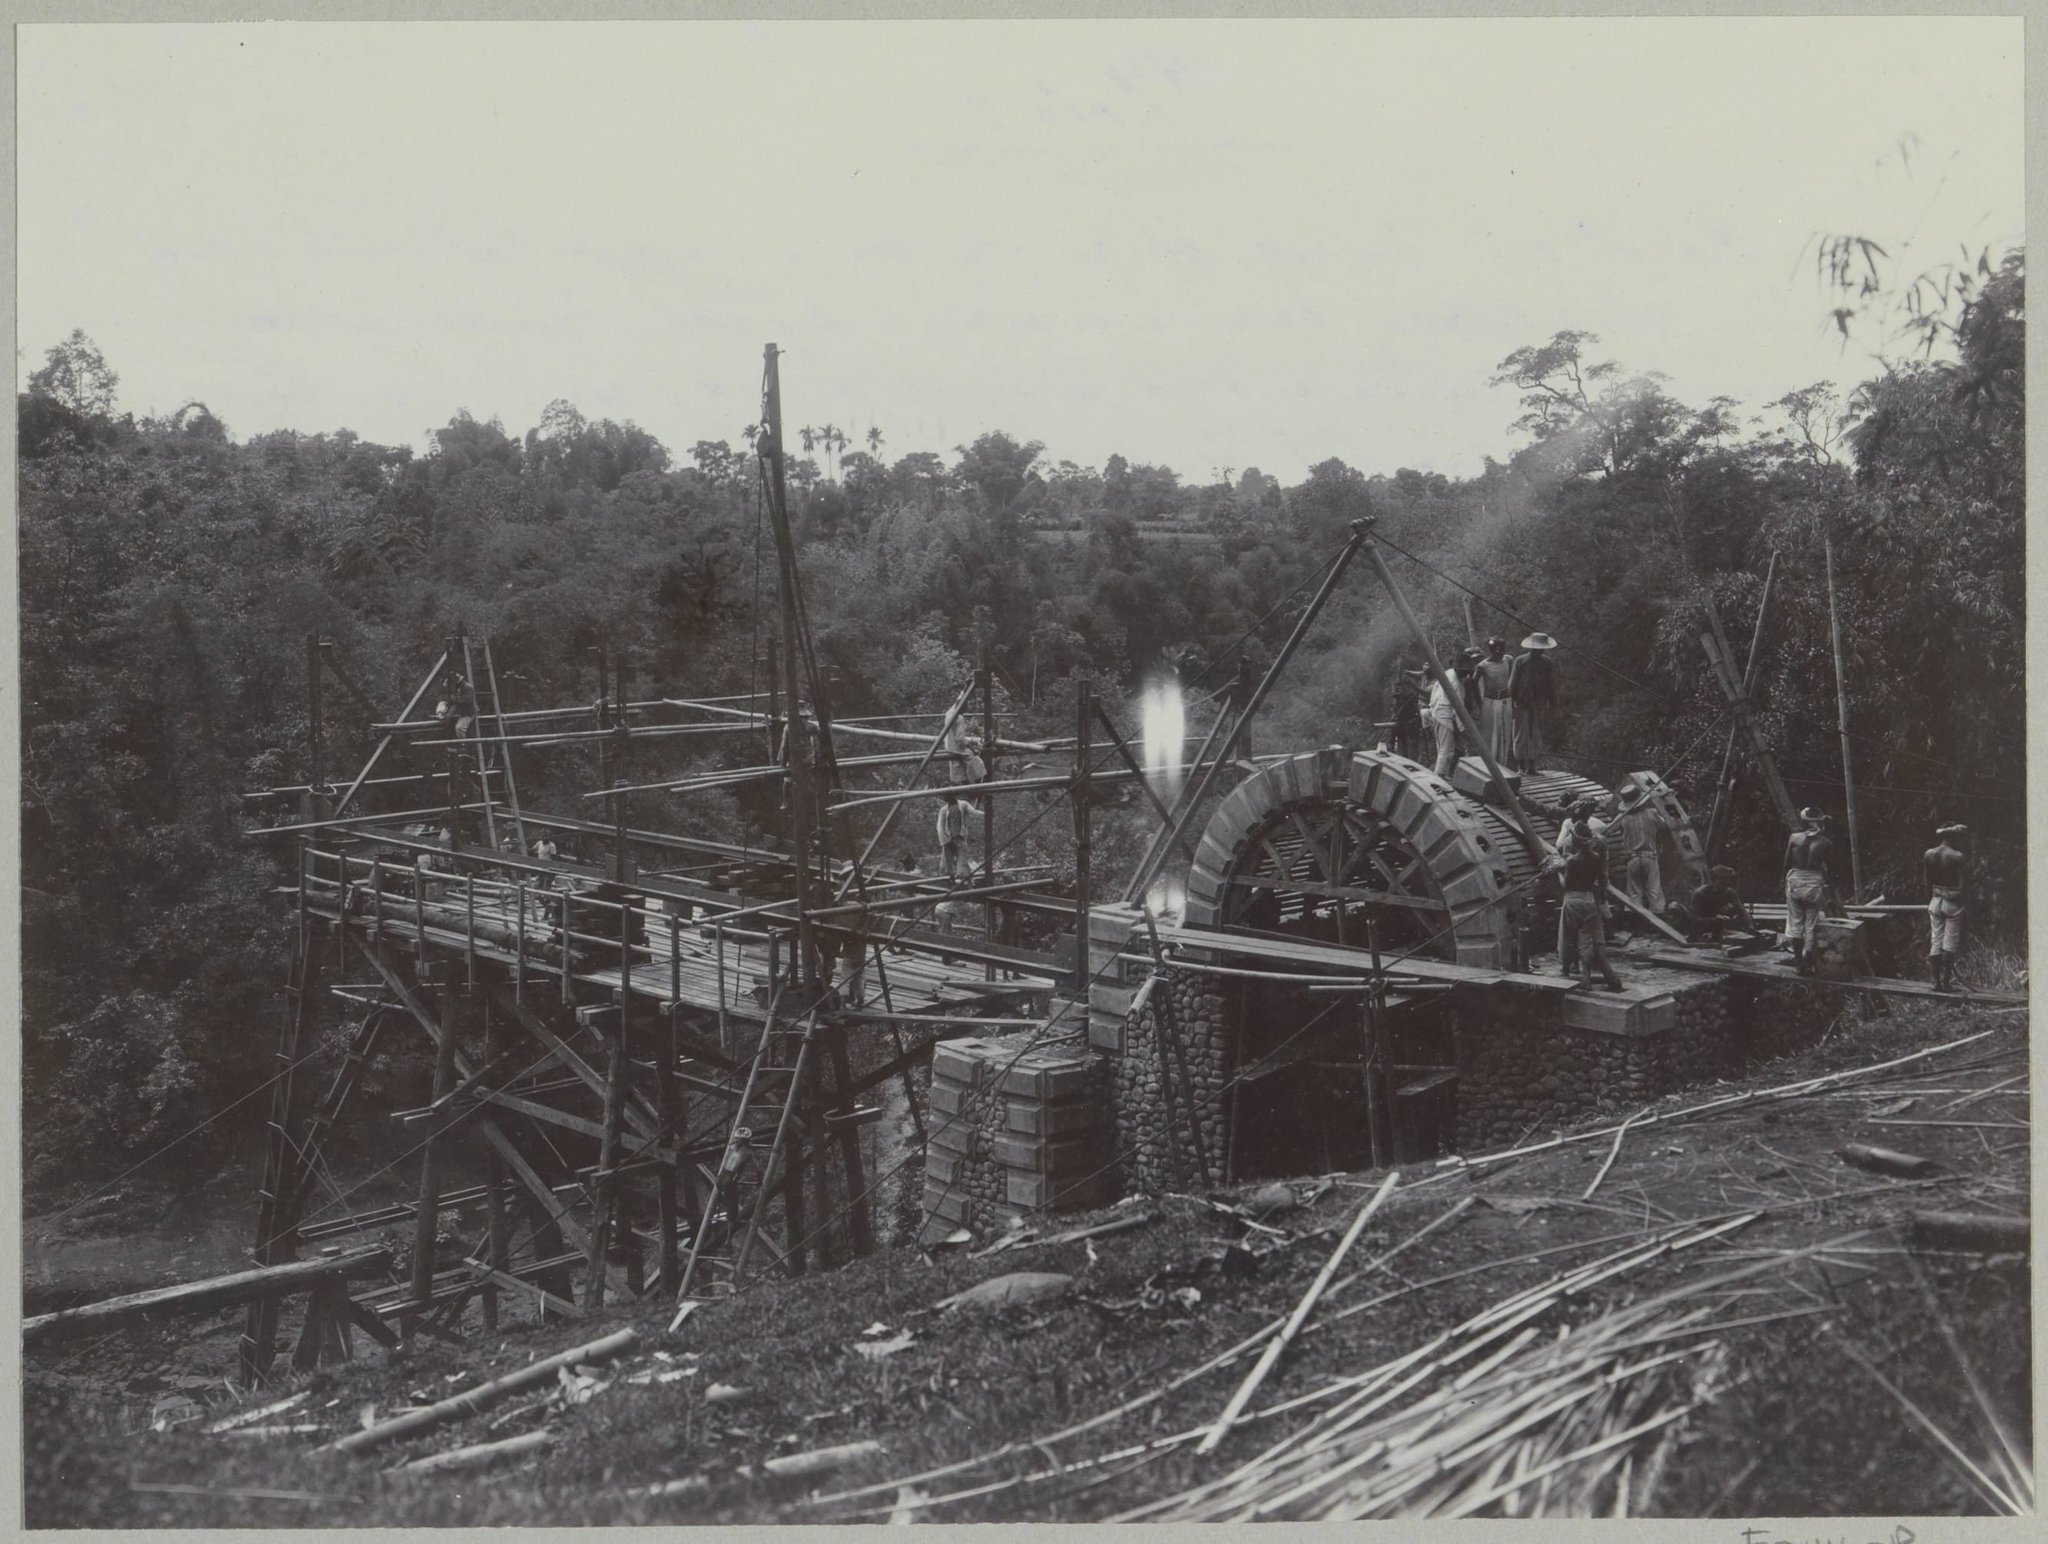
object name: album leaf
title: Bouw van een spaarboog en brugeinde aan een landhoofd op de westelijke oever van de Kali Brantas ten zuiden van Malang (Photo XVI)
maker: Anonymous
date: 1890-1920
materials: cardboard, paper, photographic support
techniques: gelatin silver print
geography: java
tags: scaffold (~ building activities), engineering, landscape with bridge, viaduct or aqueduct, working class, labourers, bridge, building-site, java, dutch east indies, the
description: Foto met op de linkerpagina het bijbehorende bijschrift. Onderdeel van Fotoalbum met opnames van de bouw van een brug over de Kali Brantas ten zuiden van Malang op Java.